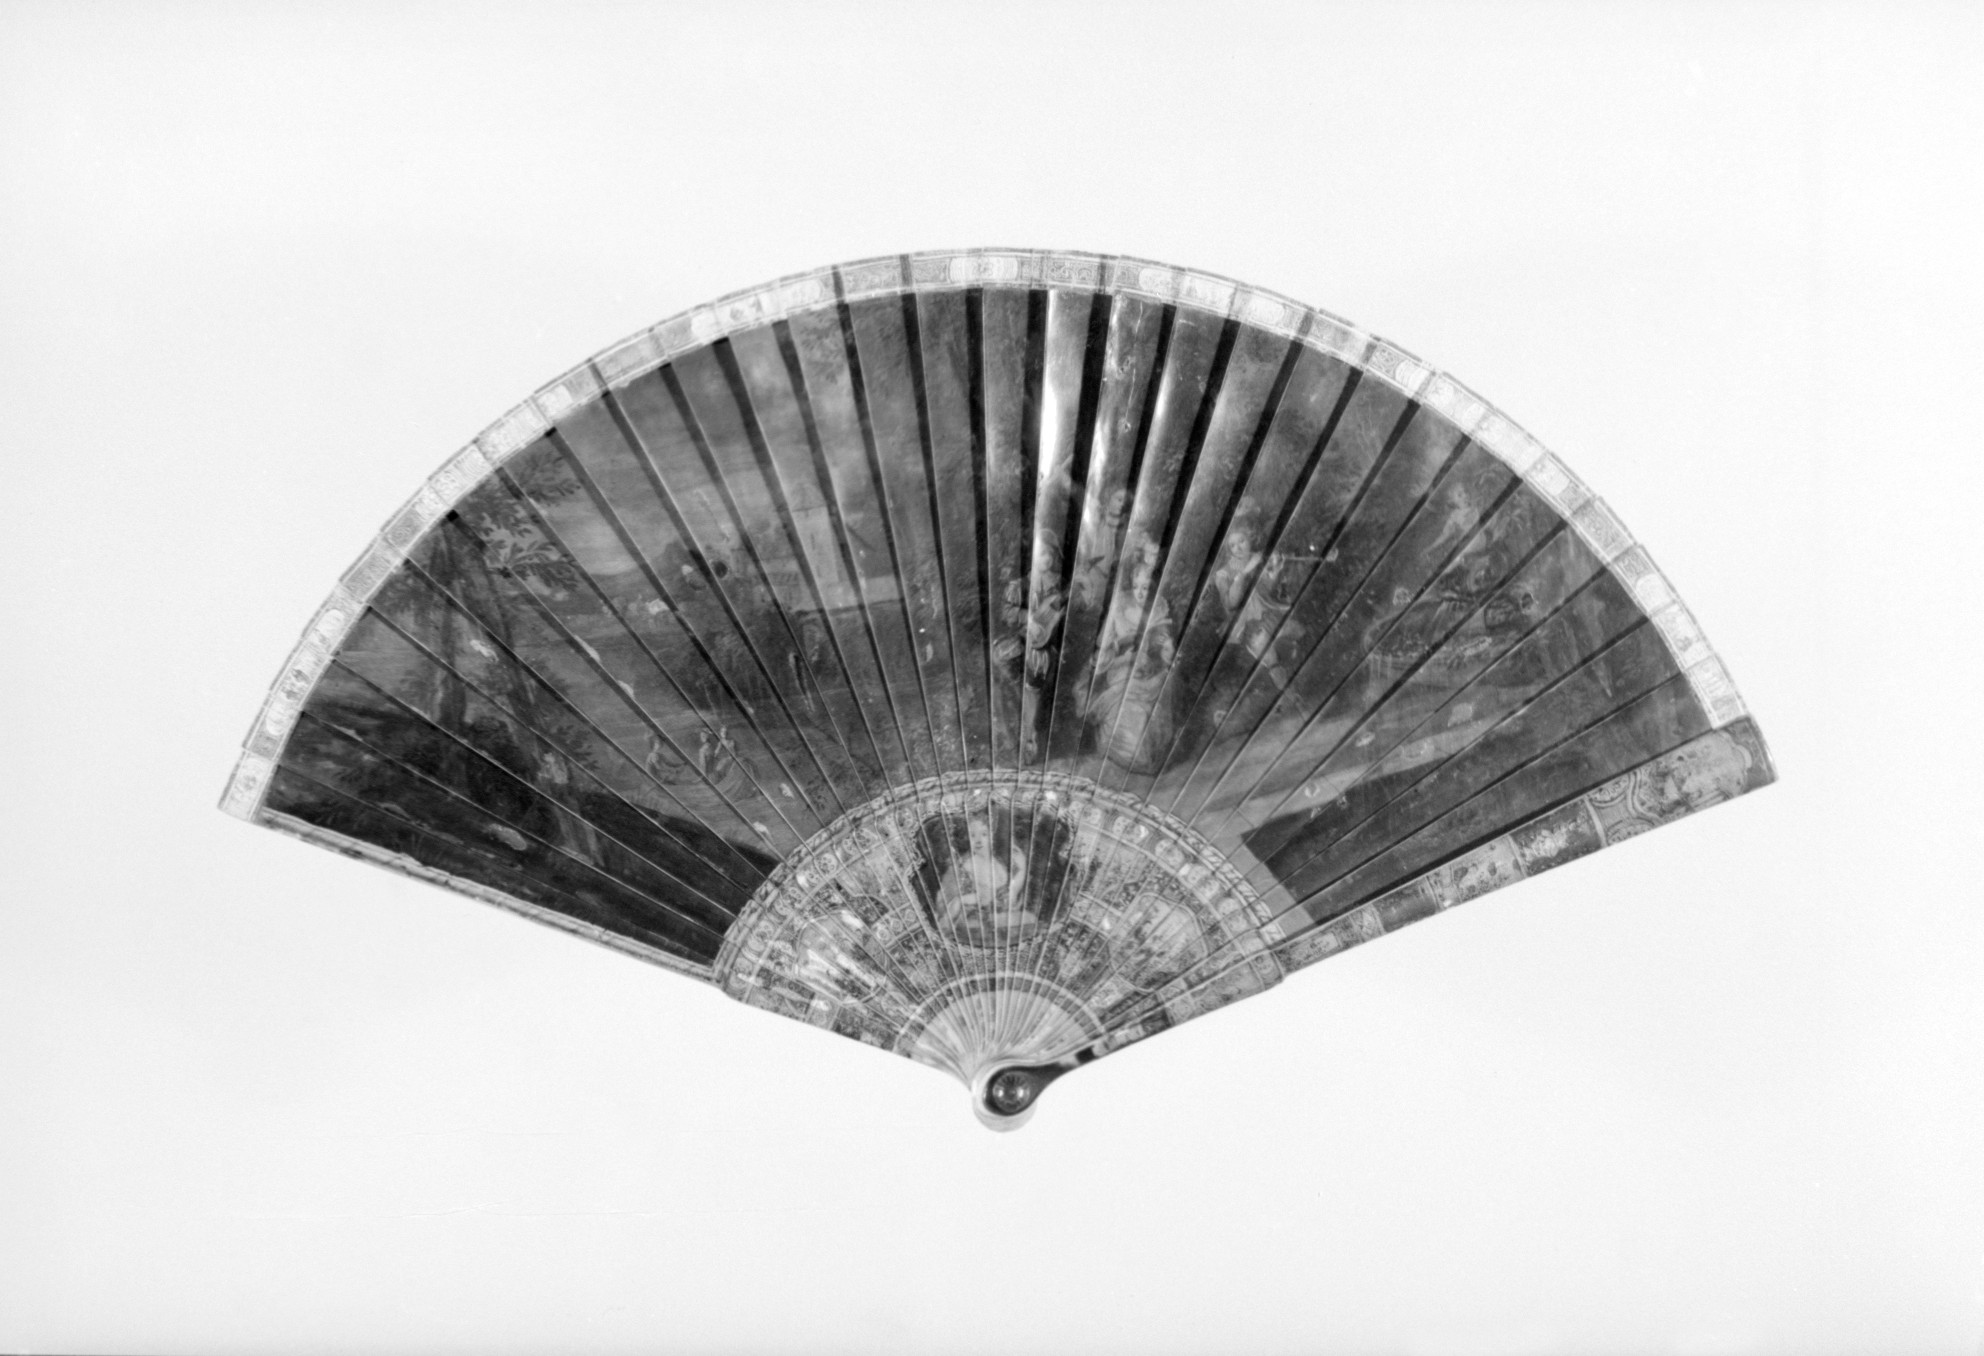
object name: fan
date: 1701-1800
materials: ivory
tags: musical instruments,men,women